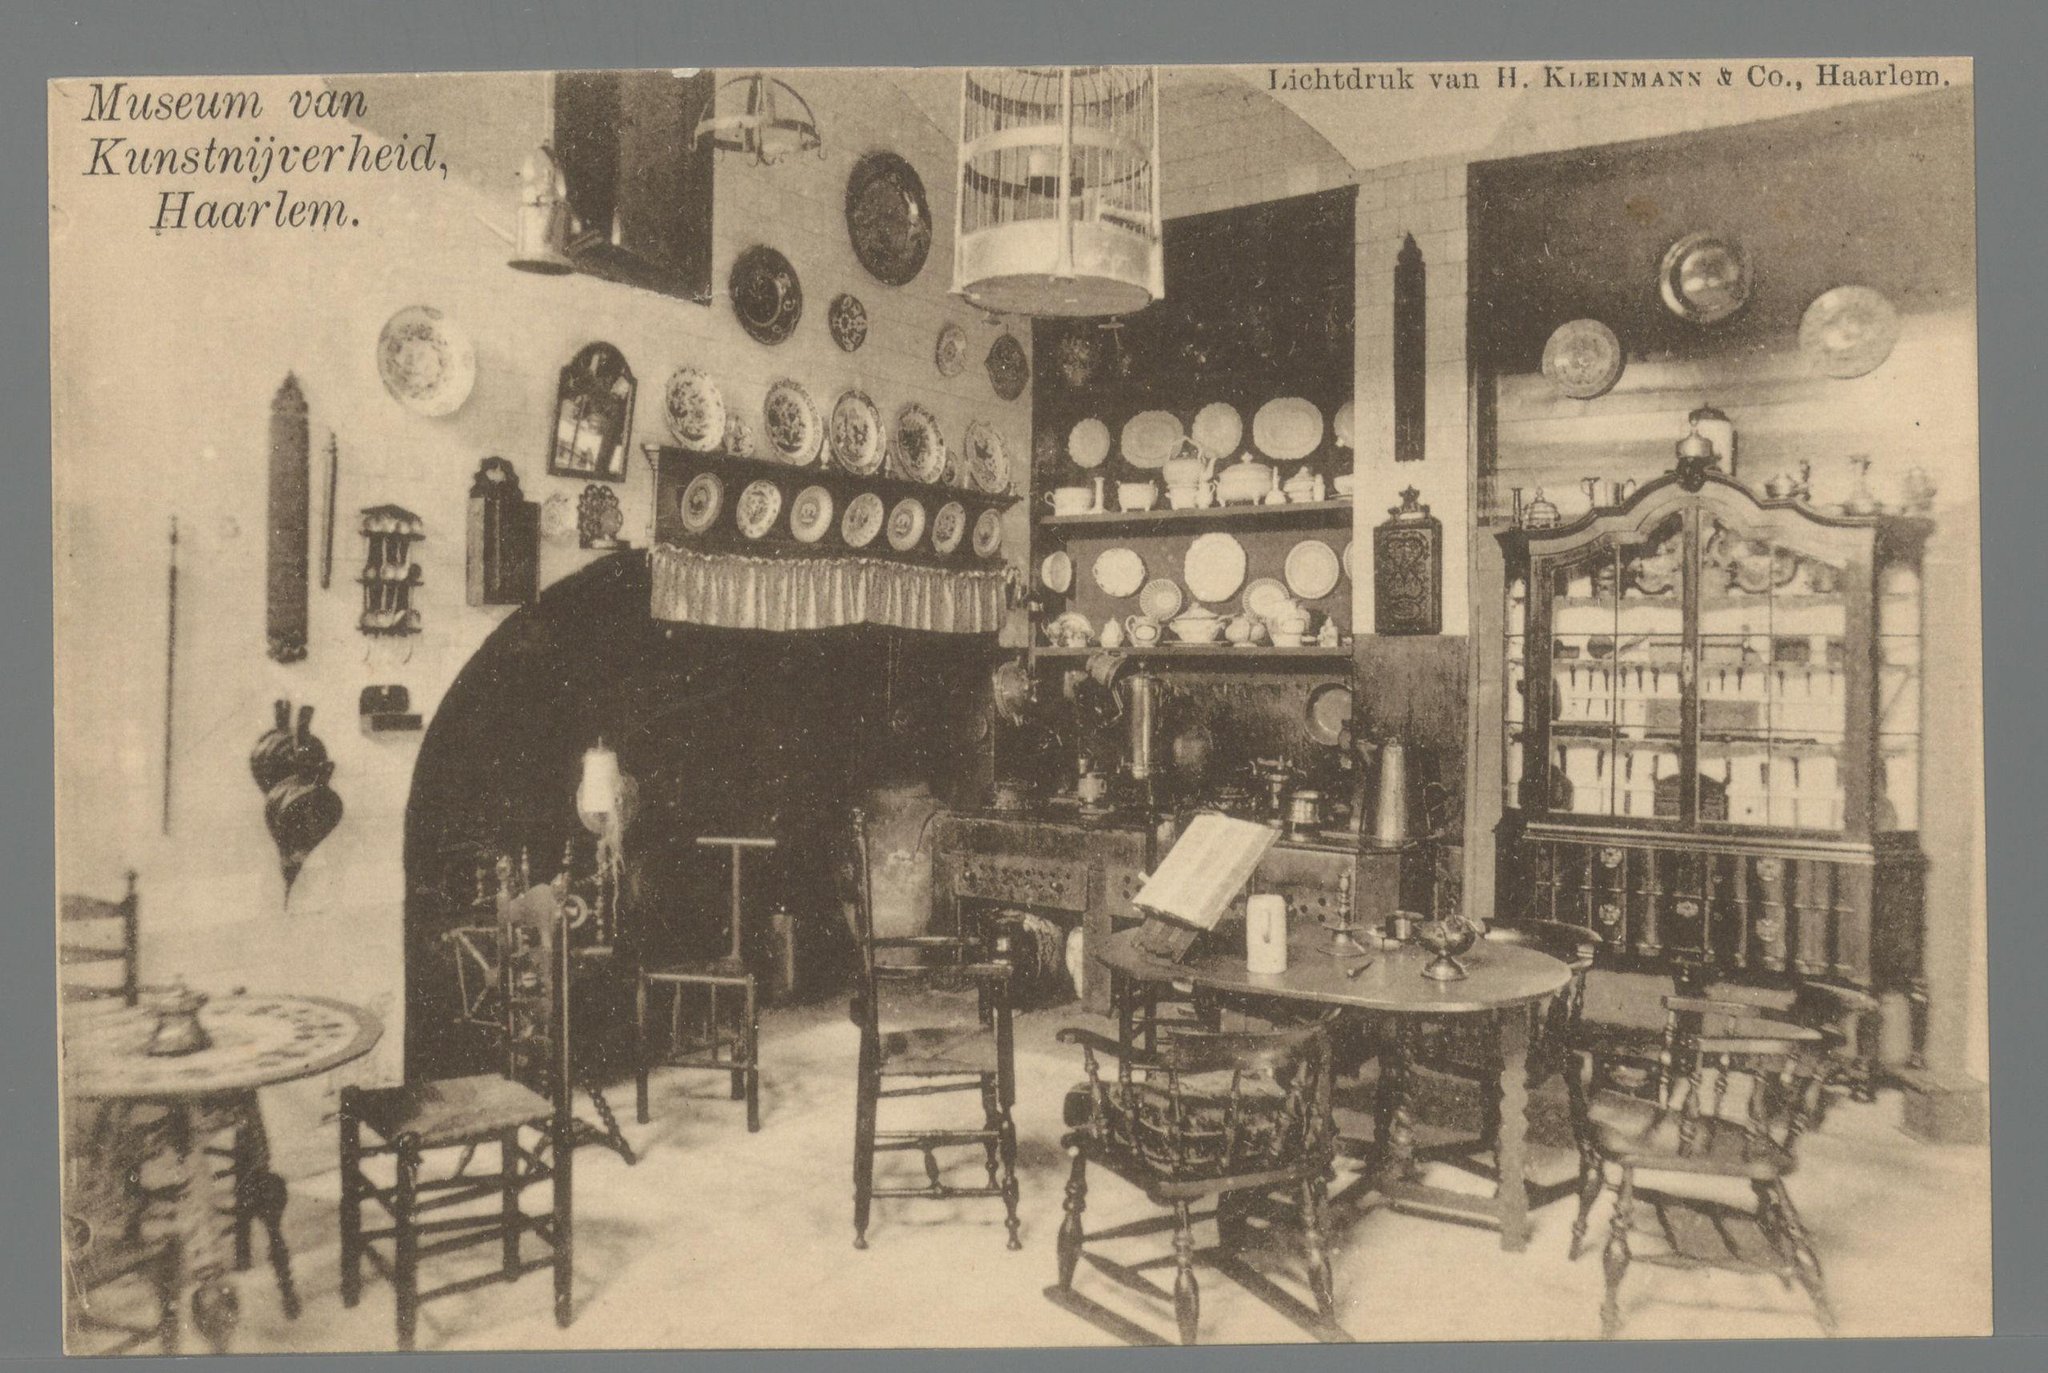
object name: photomechanical print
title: Museum van Kunstnijverheid, Haarlem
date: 1906-1910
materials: cardboard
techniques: photograph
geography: haarlem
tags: interior of the house, permanent exhibition, museum, haarlem